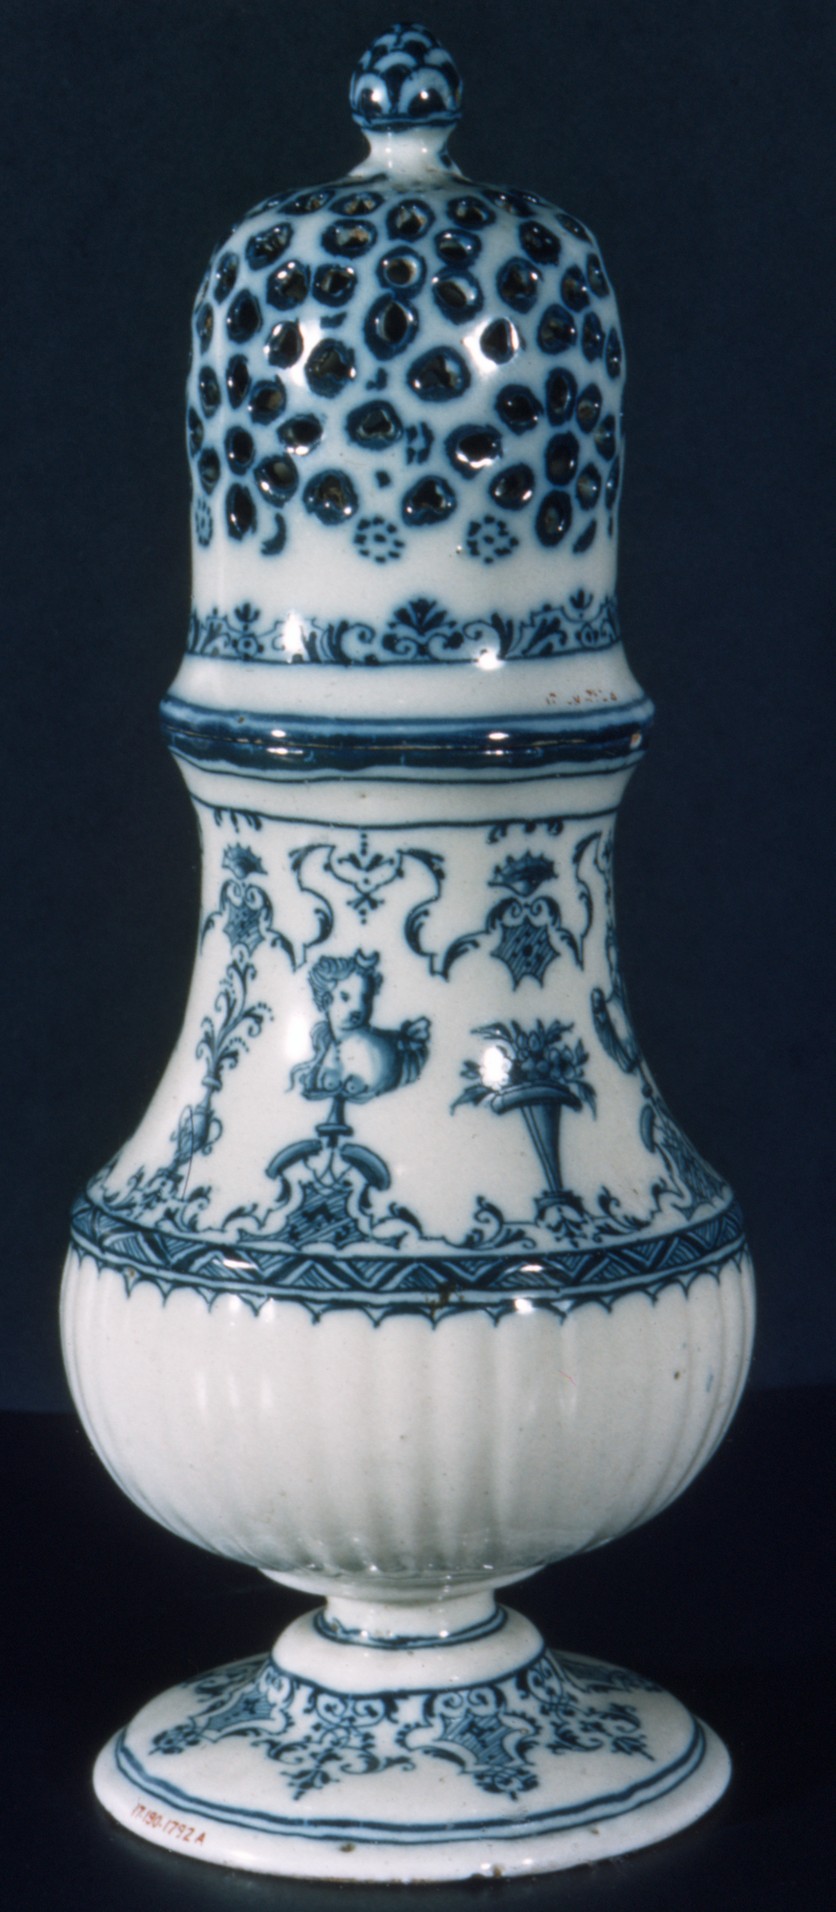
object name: sugar sifter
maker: laufier-ouéry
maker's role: factory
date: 1745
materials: faience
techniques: glazing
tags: flowers